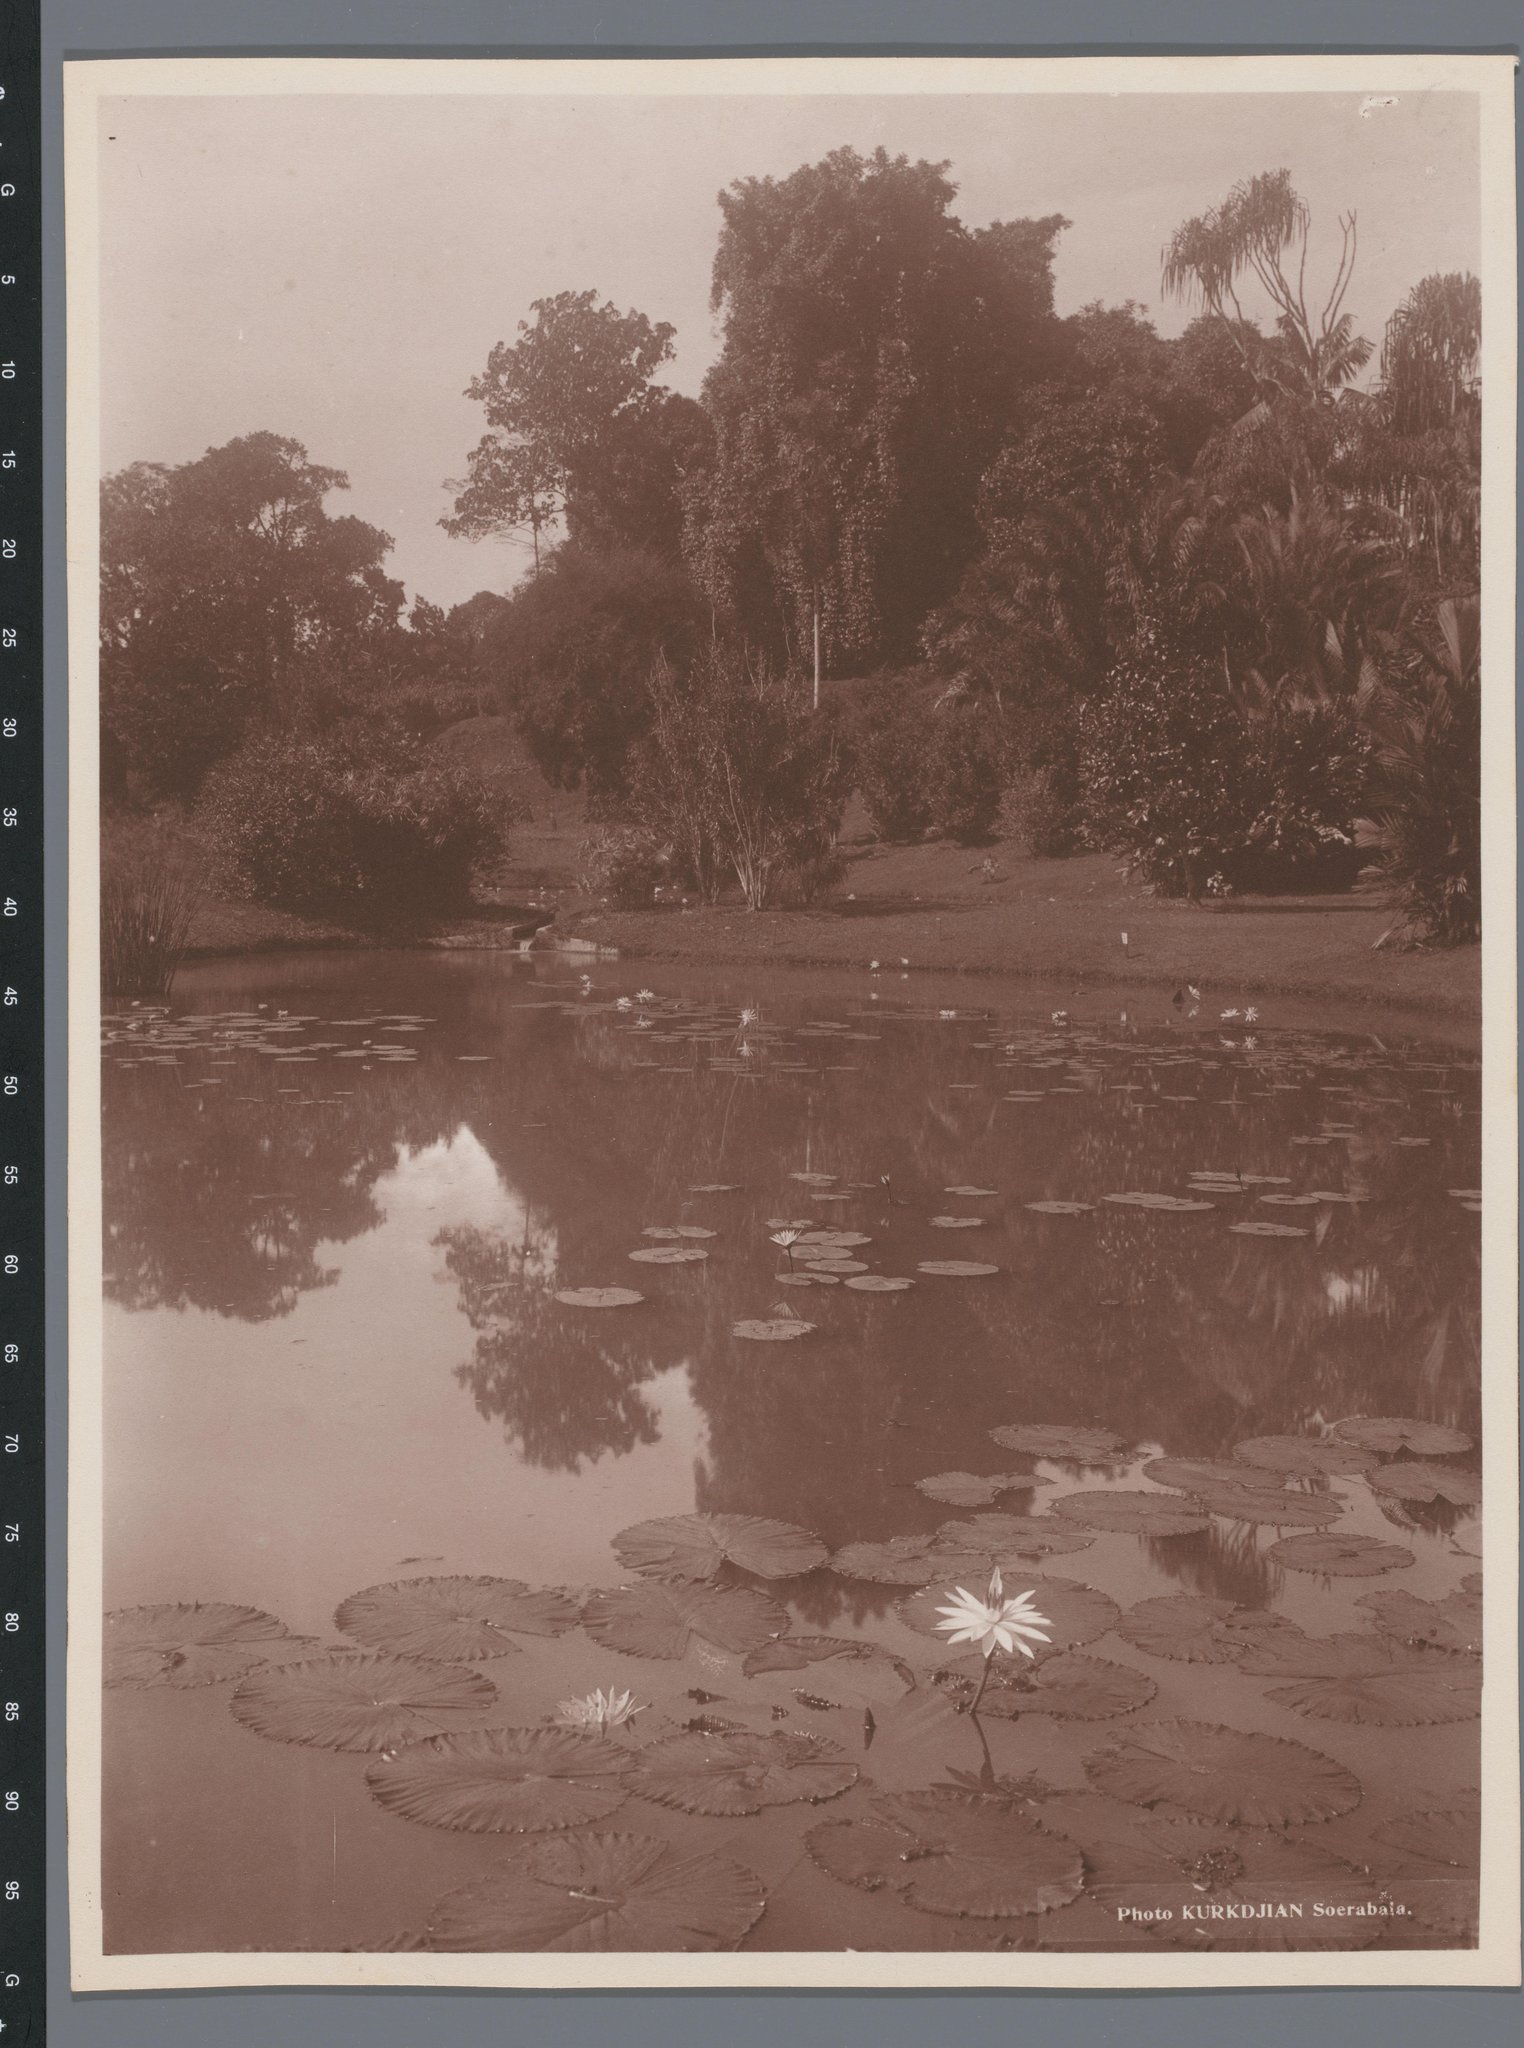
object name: photograph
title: Plantentuin Buitenzorg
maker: onnes kurkdjian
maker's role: fotograaf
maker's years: 1851-1903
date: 1890-1935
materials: paper, photographic support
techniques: gelatin silver print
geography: dutch east indies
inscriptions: title, name: ‘Photo Kurkdjian Soerabaia’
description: Een grote vijver met waterlelies in de plantentuin van Buitenzorg.